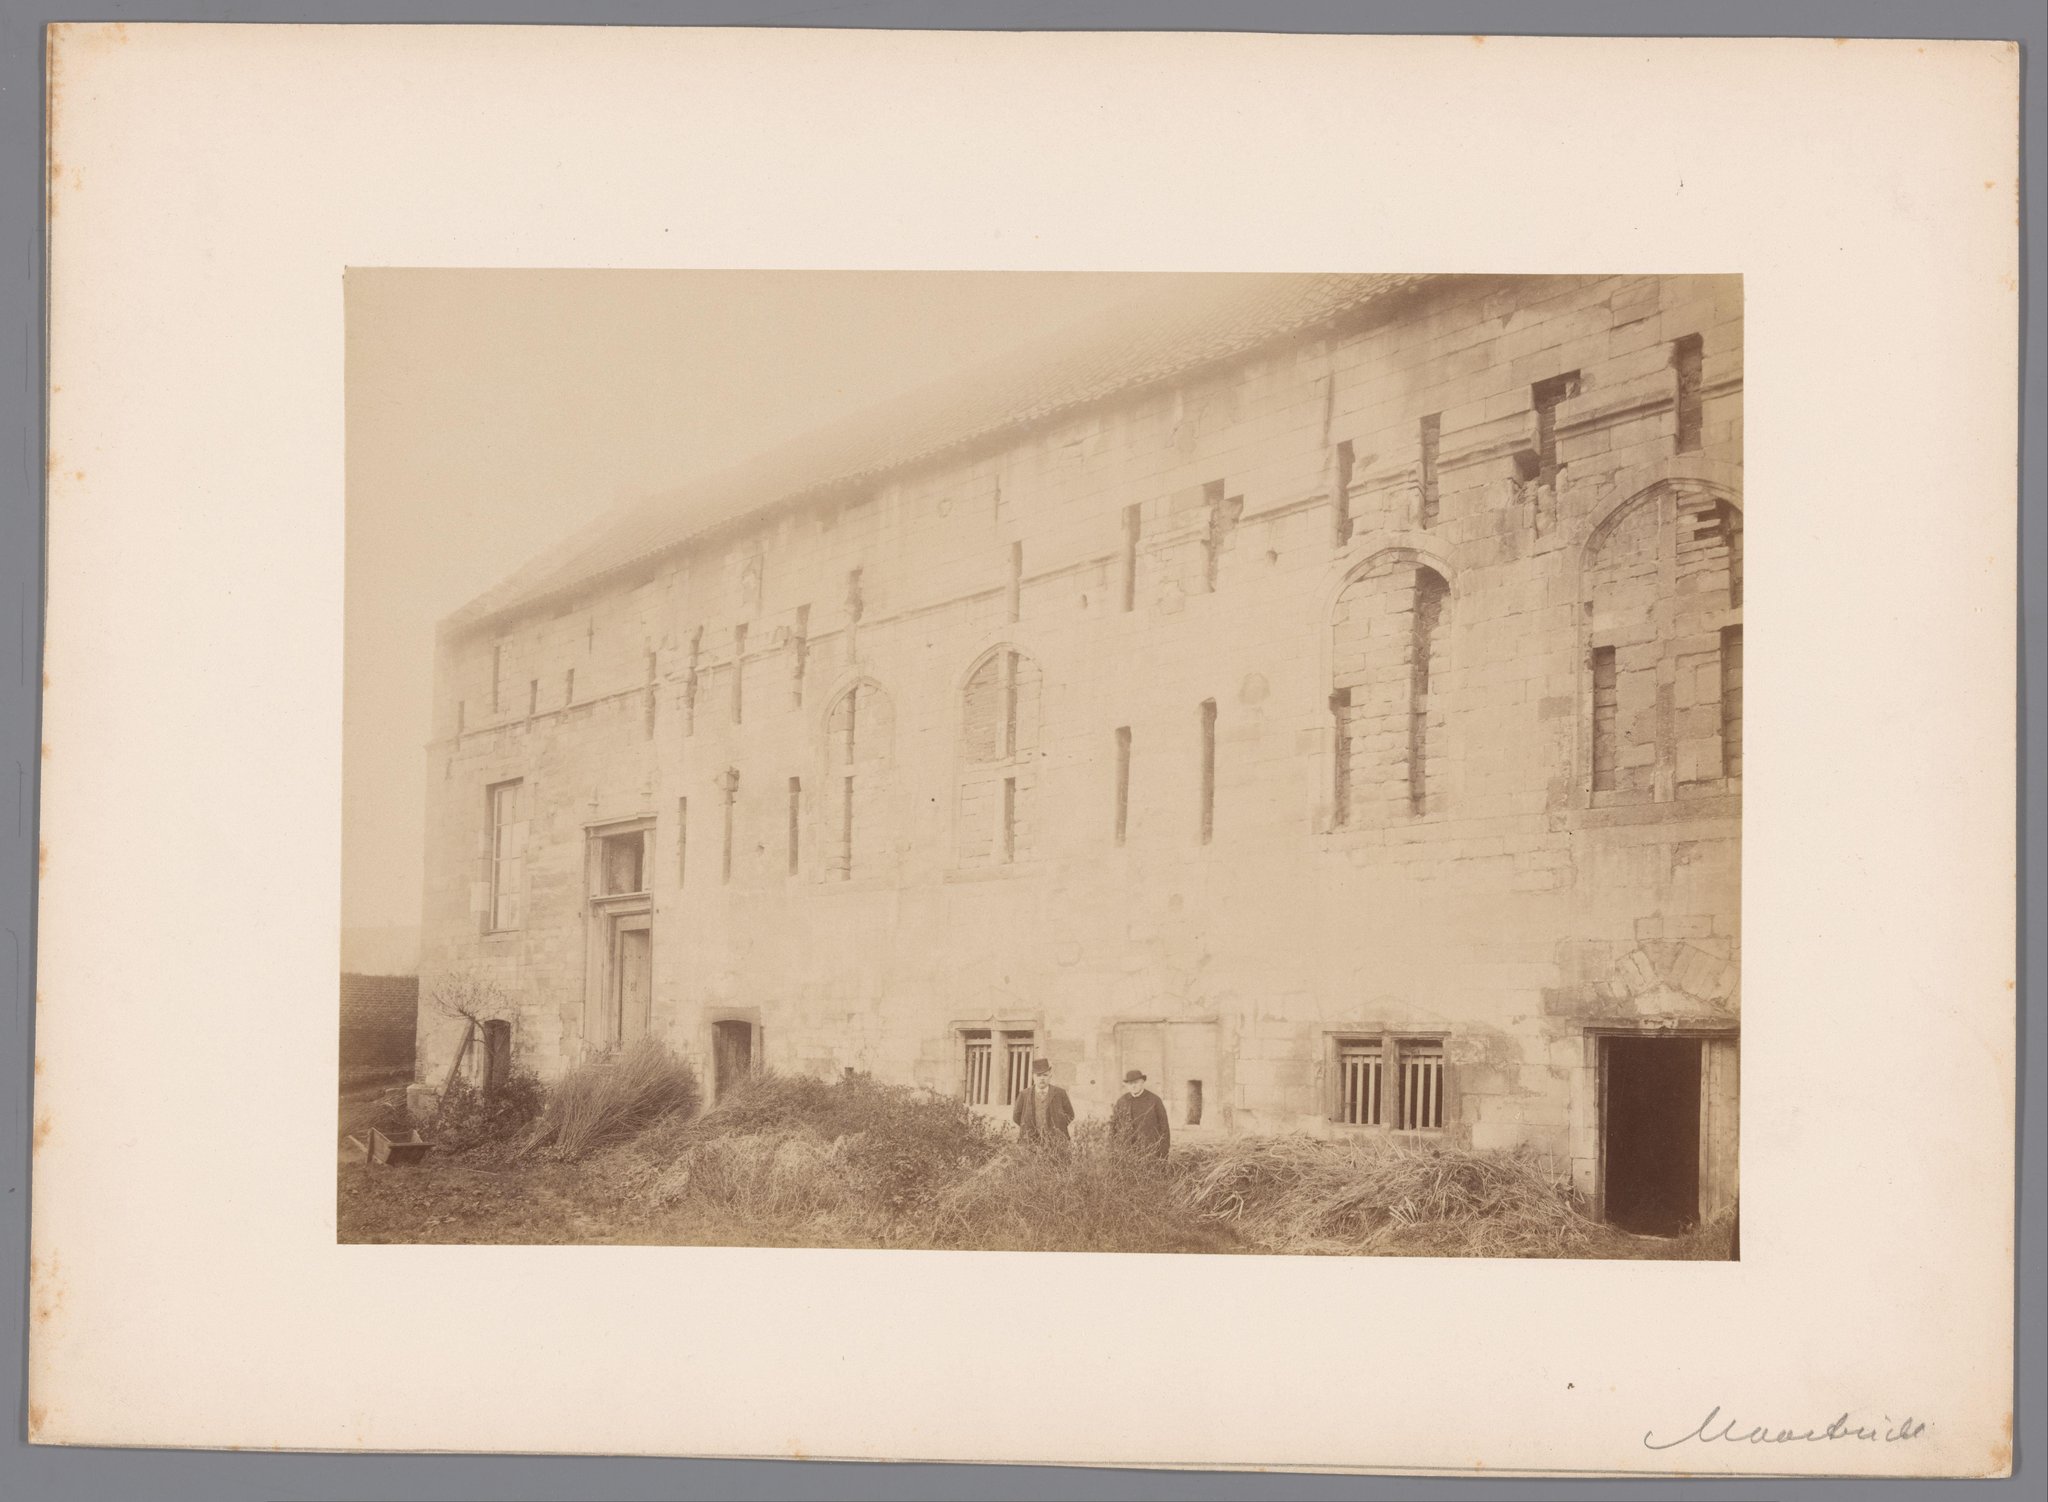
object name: photograph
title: Gedeelte van het oude Beyart klooster te Maastricht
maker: anoniem (monumentenzorg)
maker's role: fotograaf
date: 1893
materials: cardboard, photographic support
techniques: albumen print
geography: maastricht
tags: ruin of church, monastery, etc.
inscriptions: annotation: ‘Maastricht (L.)/ Beyaertgebouwen/ gezien vanaf punt e./ 1893’, annotation: ‘Maastricht’